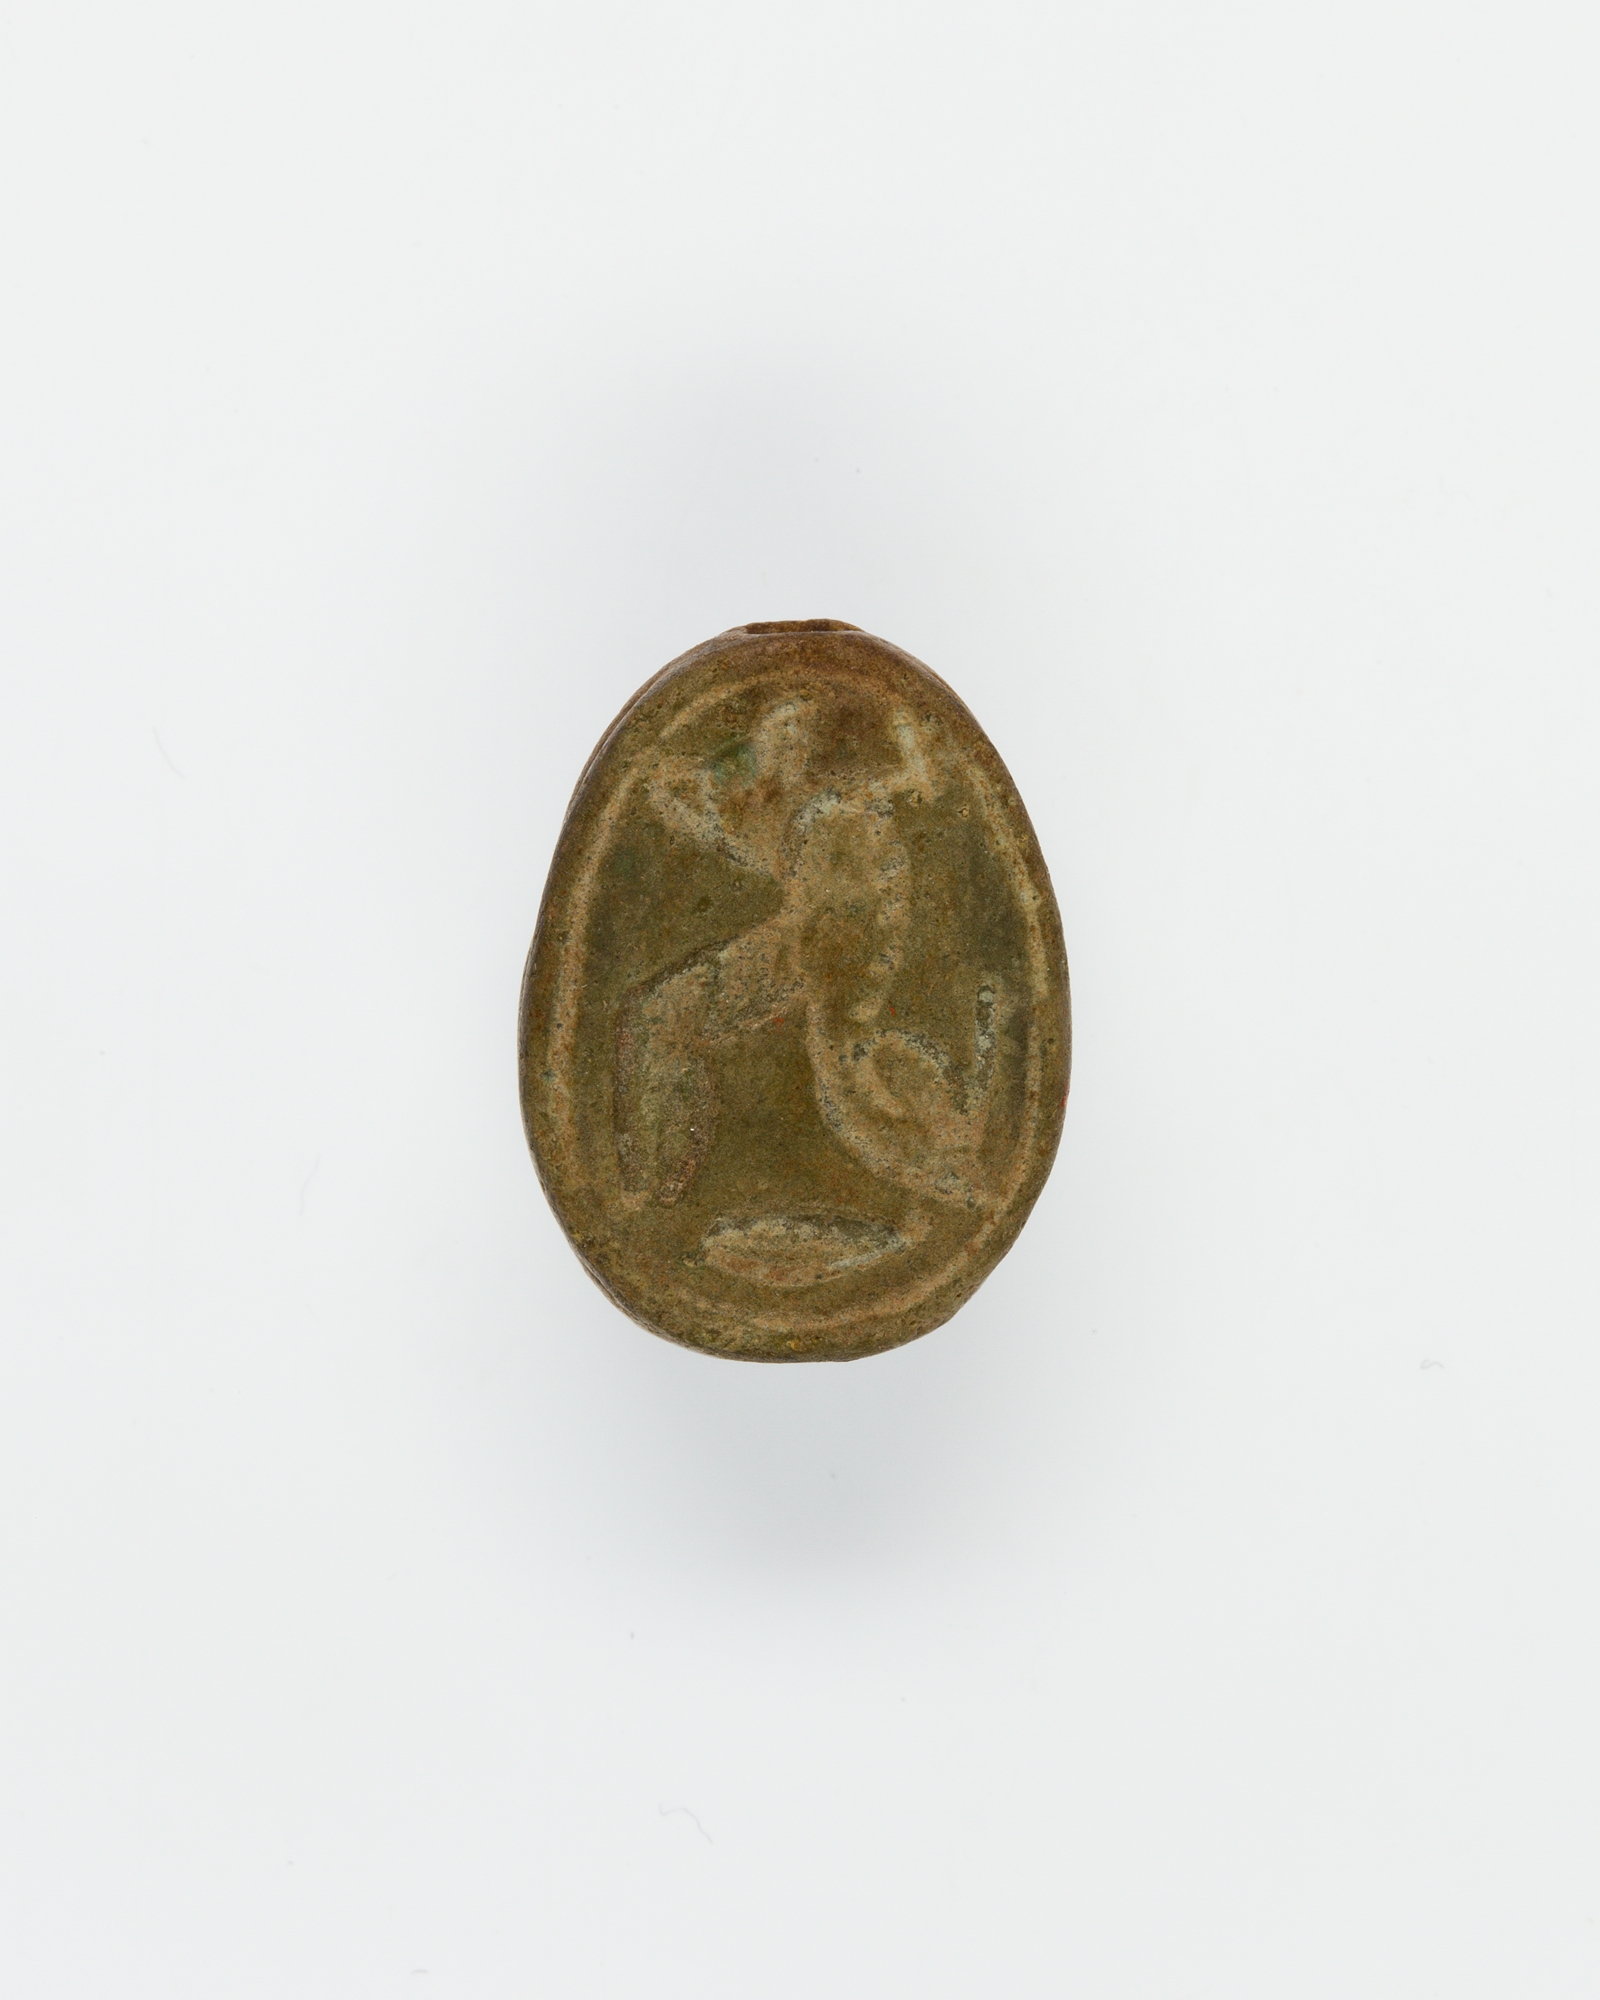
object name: scarab, griffin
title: Scarab depicting a griffin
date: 1786-1482 BCE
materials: paste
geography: egypt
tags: griffins,scarabs